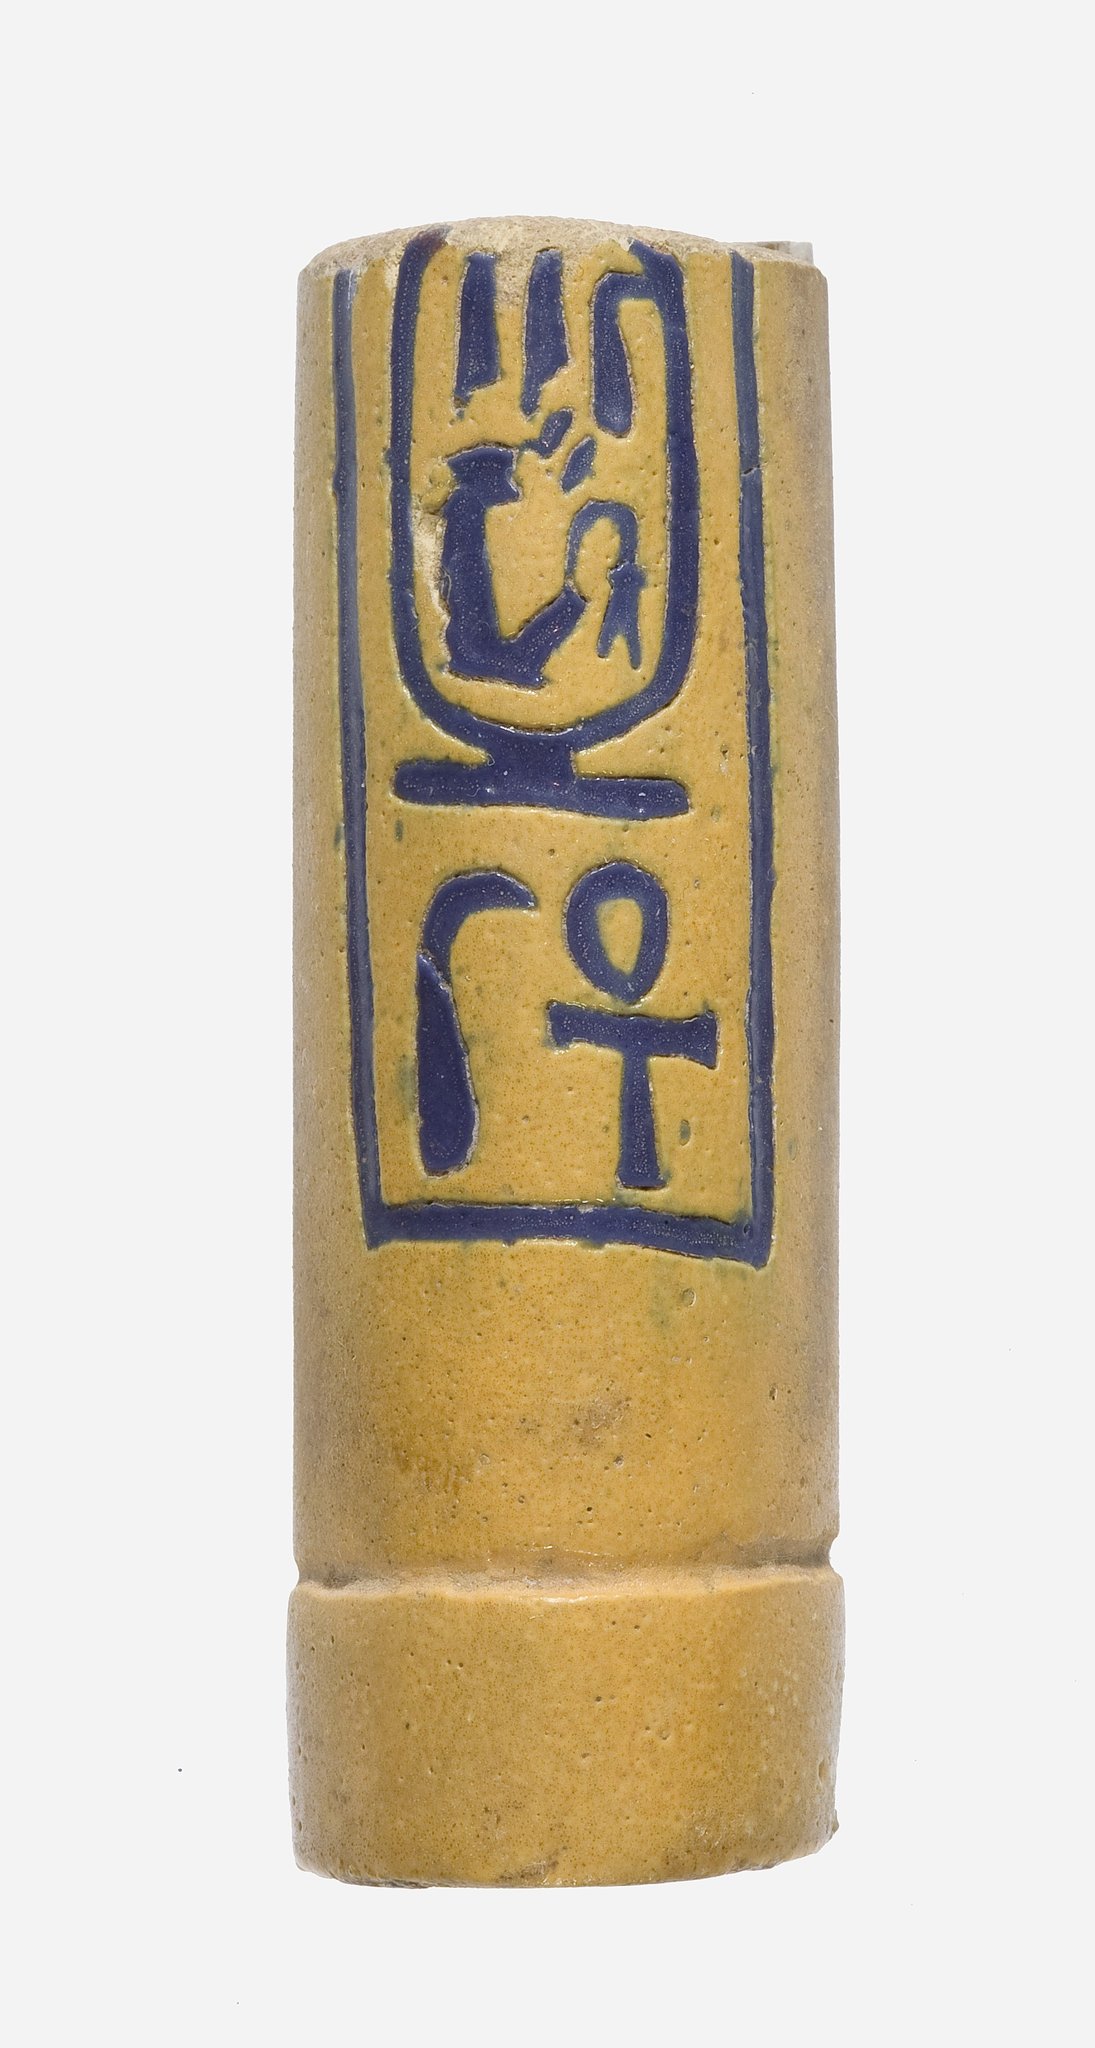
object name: kohl tube, tiye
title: Lower Half of Kohl Tube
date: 1390-1352 BCE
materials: faience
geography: egypt